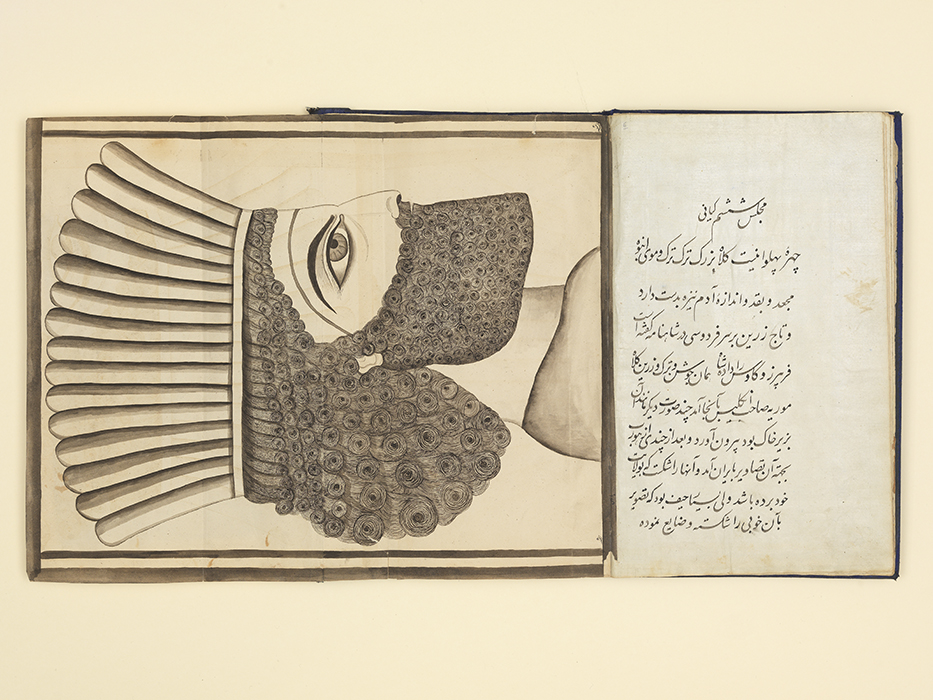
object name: persian travelogue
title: Persian Travelogue: A Diary of a Journey through the region of Fars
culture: qajar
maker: ahmad naqqash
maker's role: artist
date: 1838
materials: cord, cotton, hemp, ink, paper, velvet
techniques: bookbinding, marbling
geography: iran